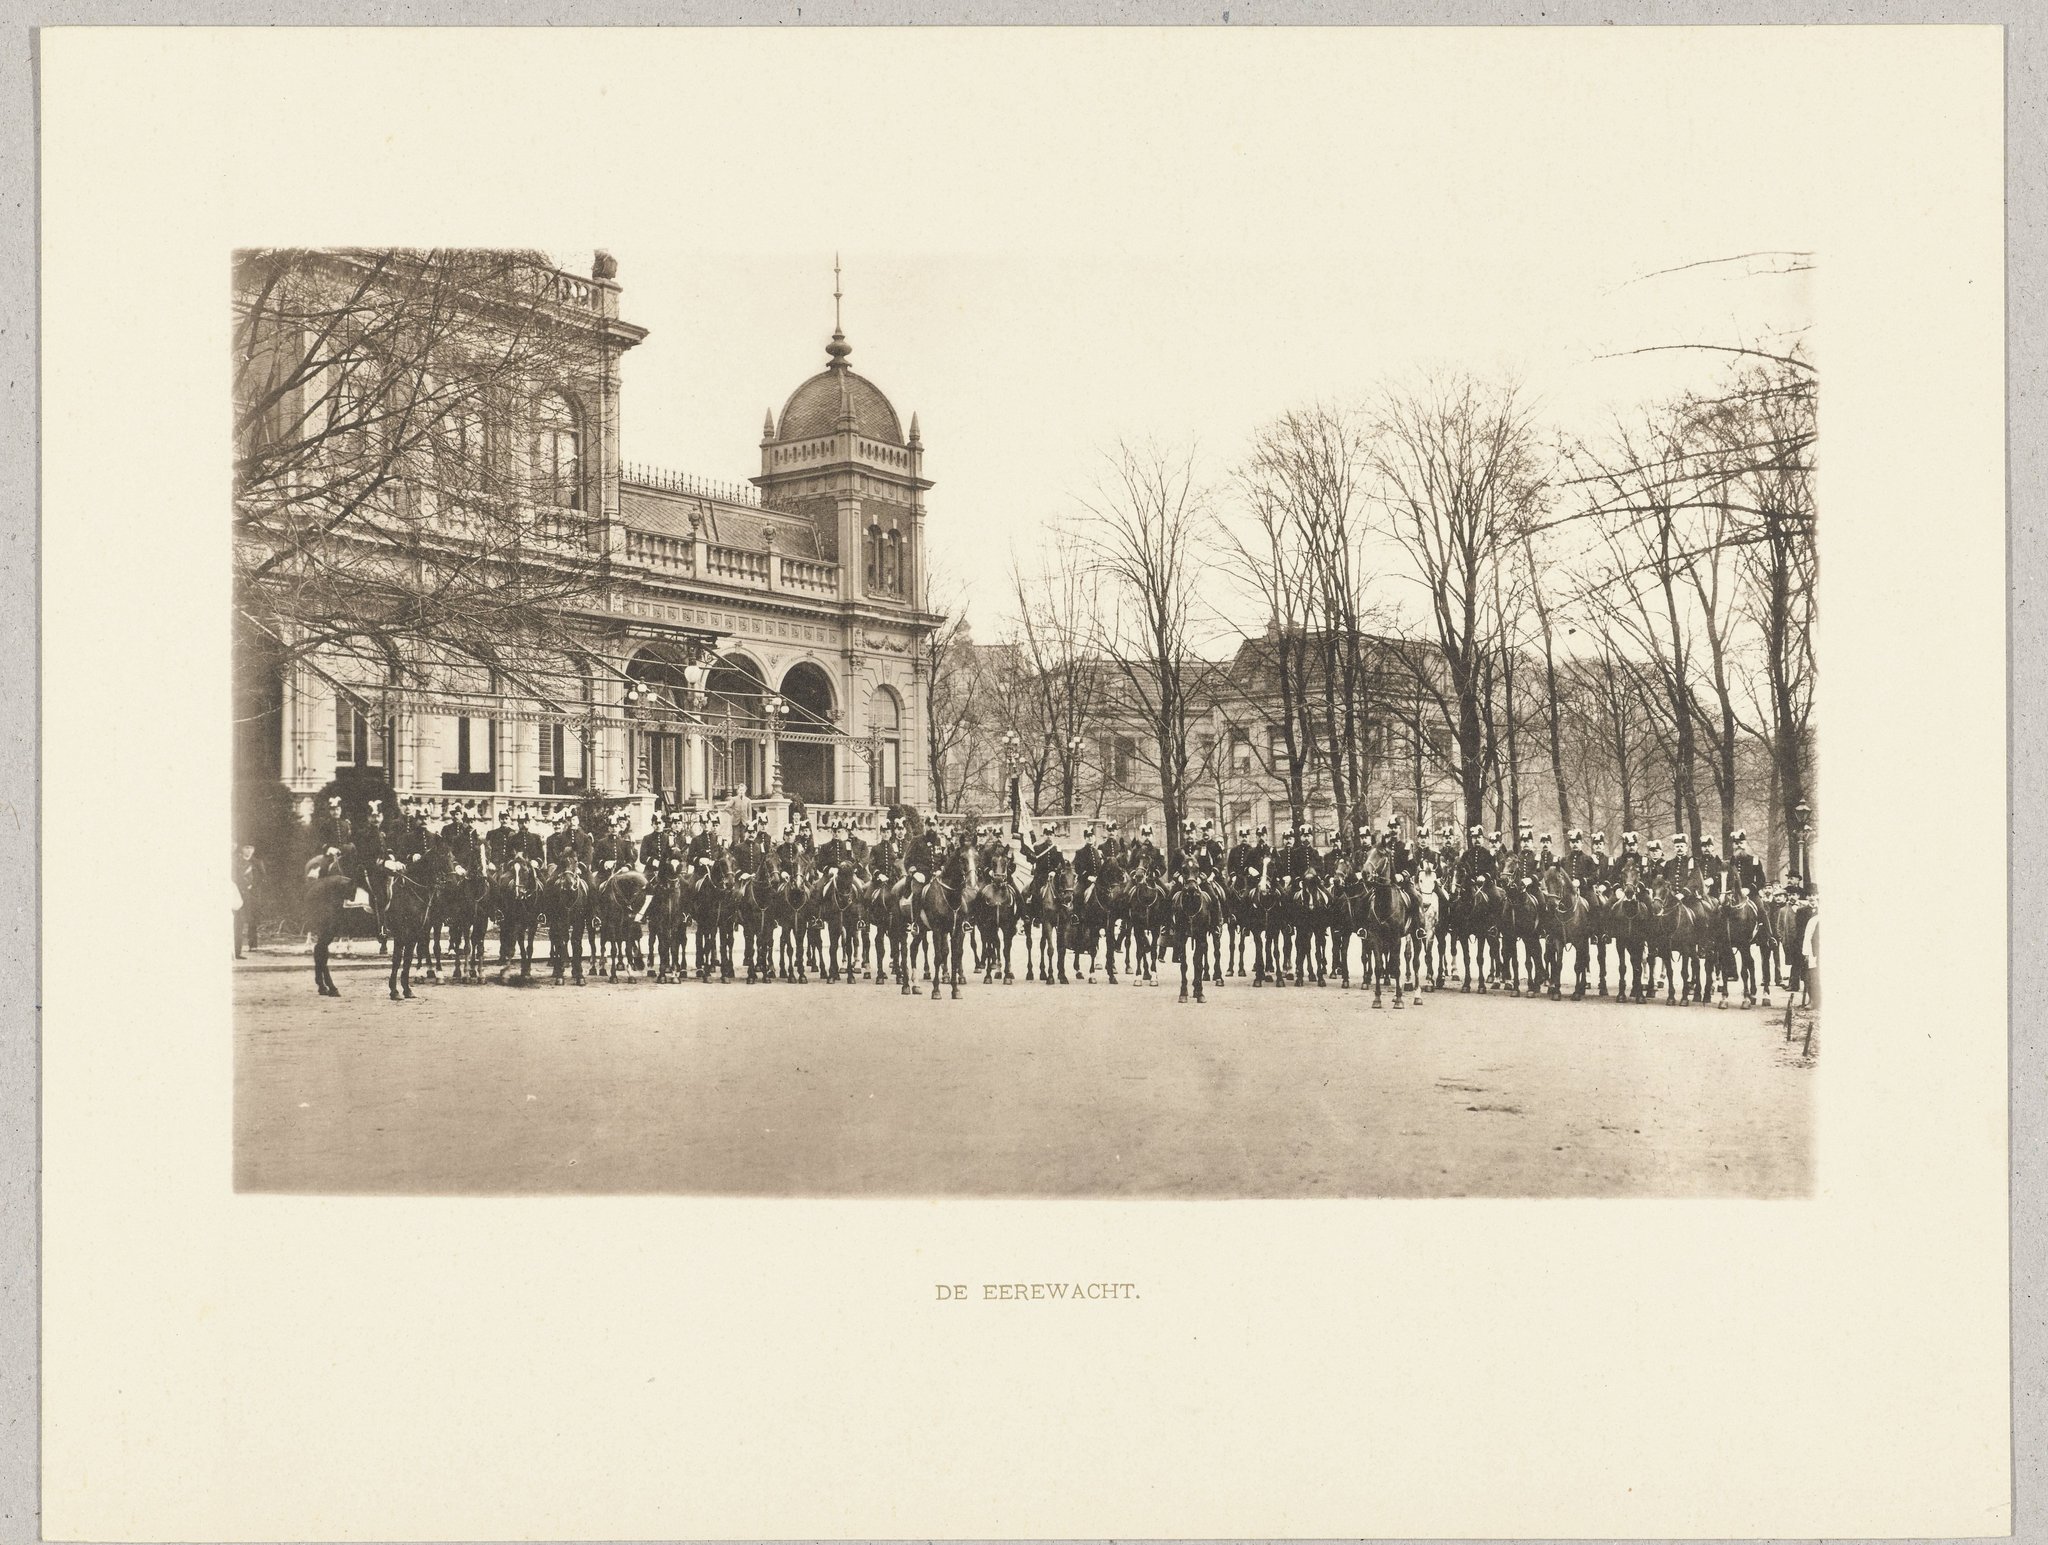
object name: photograph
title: Erewacht bij het Vondelparkpaviljoen in Amsterdam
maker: barend groote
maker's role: fotograaf, fotohandel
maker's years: 1862-1946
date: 1901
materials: paper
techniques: photograph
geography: amsterdam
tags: the hague, print maker, wilhelmina of the netherlands, hendrik (prins der nederlanden (1876-1934)), guard of honour, public gardens, park, historical events and situations, amsterdam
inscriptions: annotation: ‘De Eerewacht.’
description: 5 maart 1901, feestelijkheden ter gelegenheid van het huwelijk van koningin Wilhelmina en prins Hendrik